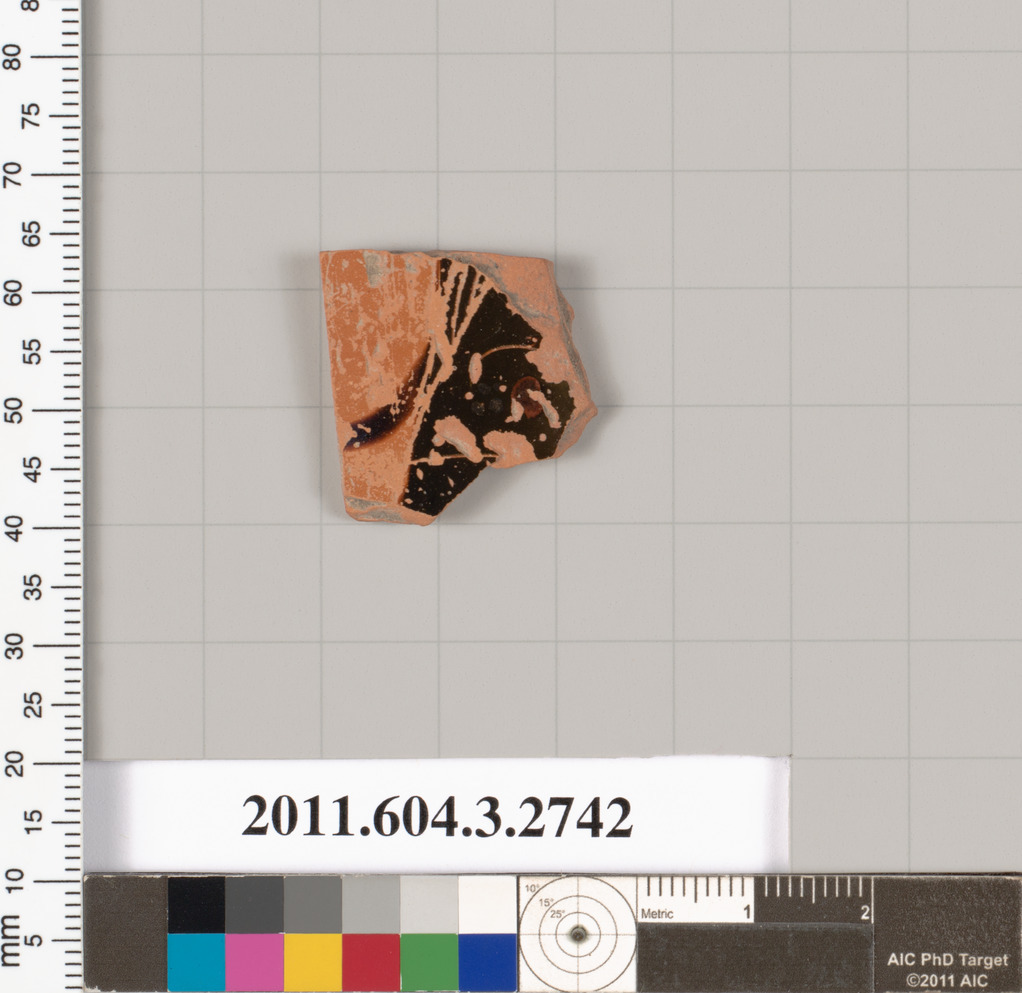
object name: oinochoe or olpe fragment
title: Terracotta fragment of an oinochoe (jug) or olpe (jug)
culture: greek, attic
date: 534-468 BCE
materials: terracotta